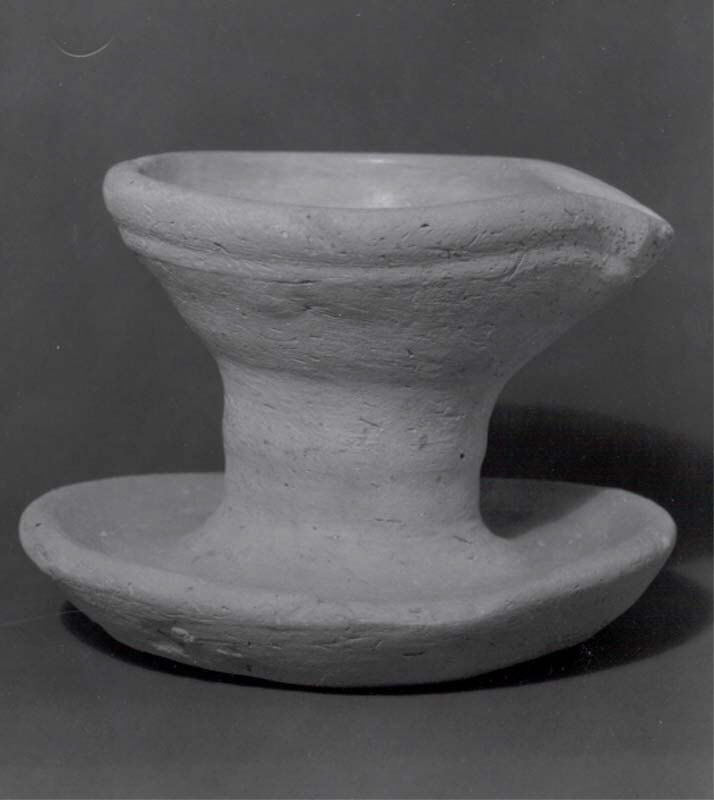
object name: lamp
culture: assyrian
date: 800-601 BCE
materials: ceramic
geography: mesopotamia